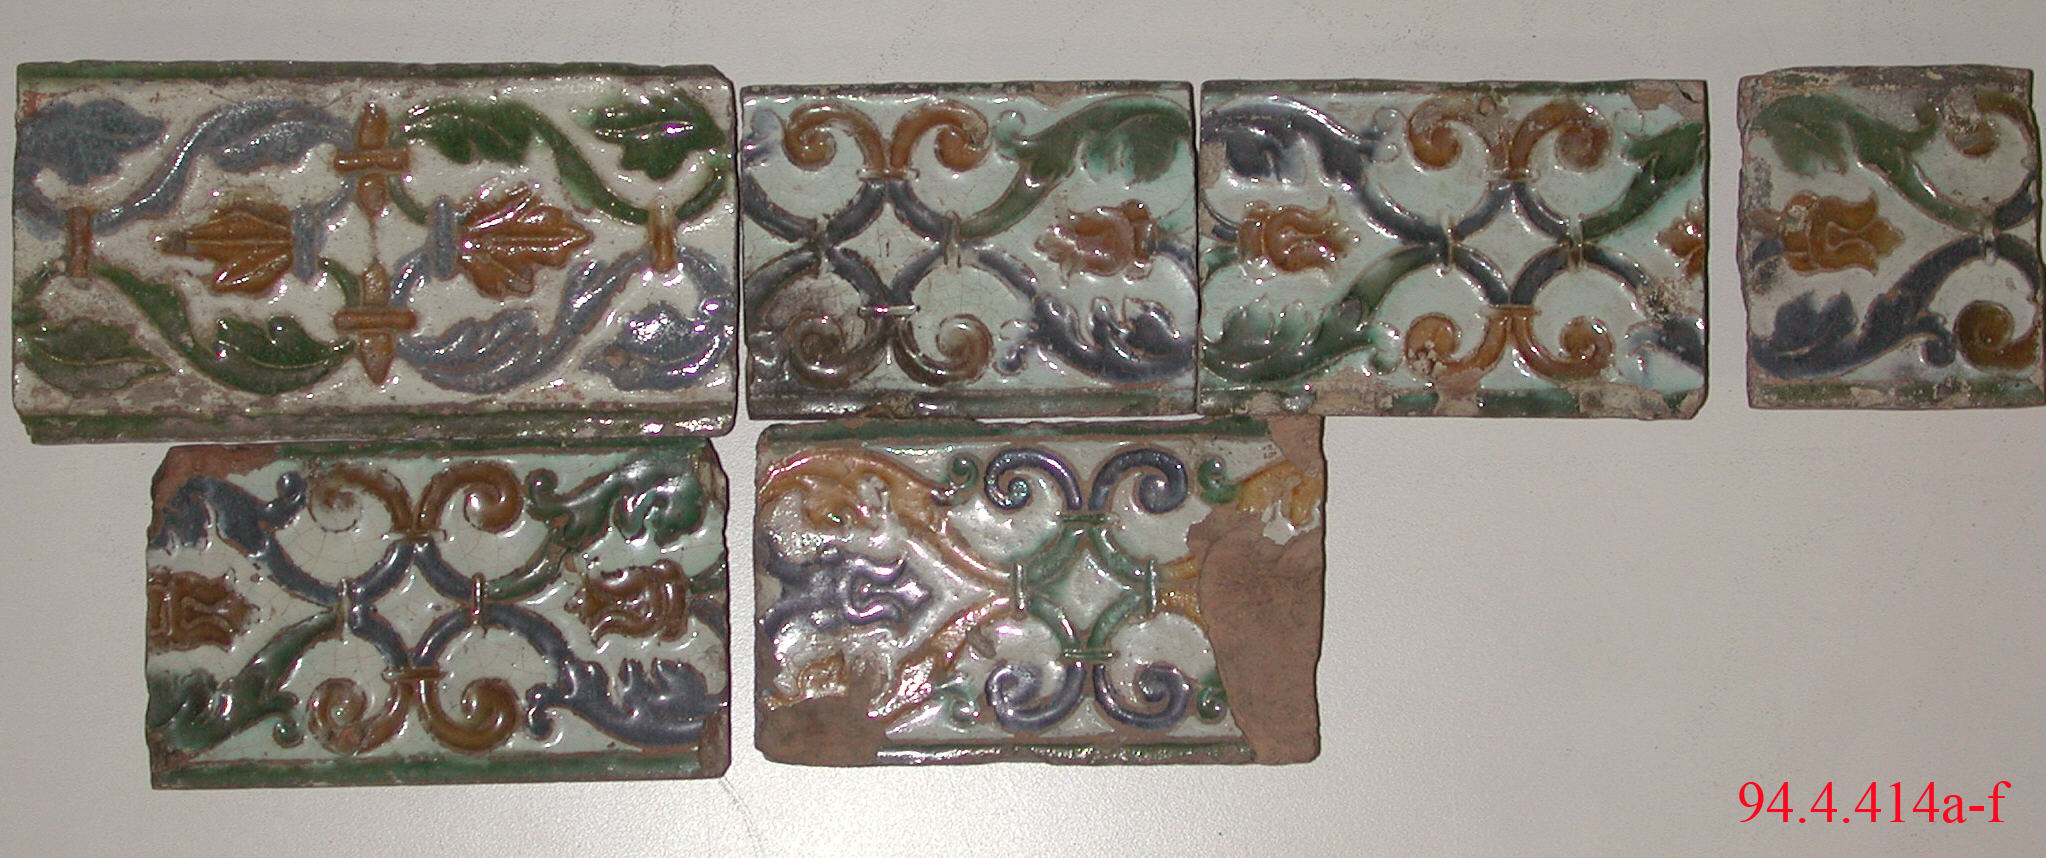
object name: tile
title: Tiles (6)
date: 1501-1700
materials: earthenware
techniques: glazing